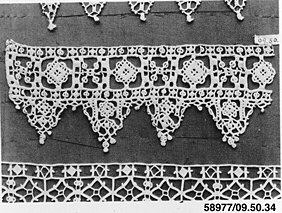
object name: fragment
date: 1601-1700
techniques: lace